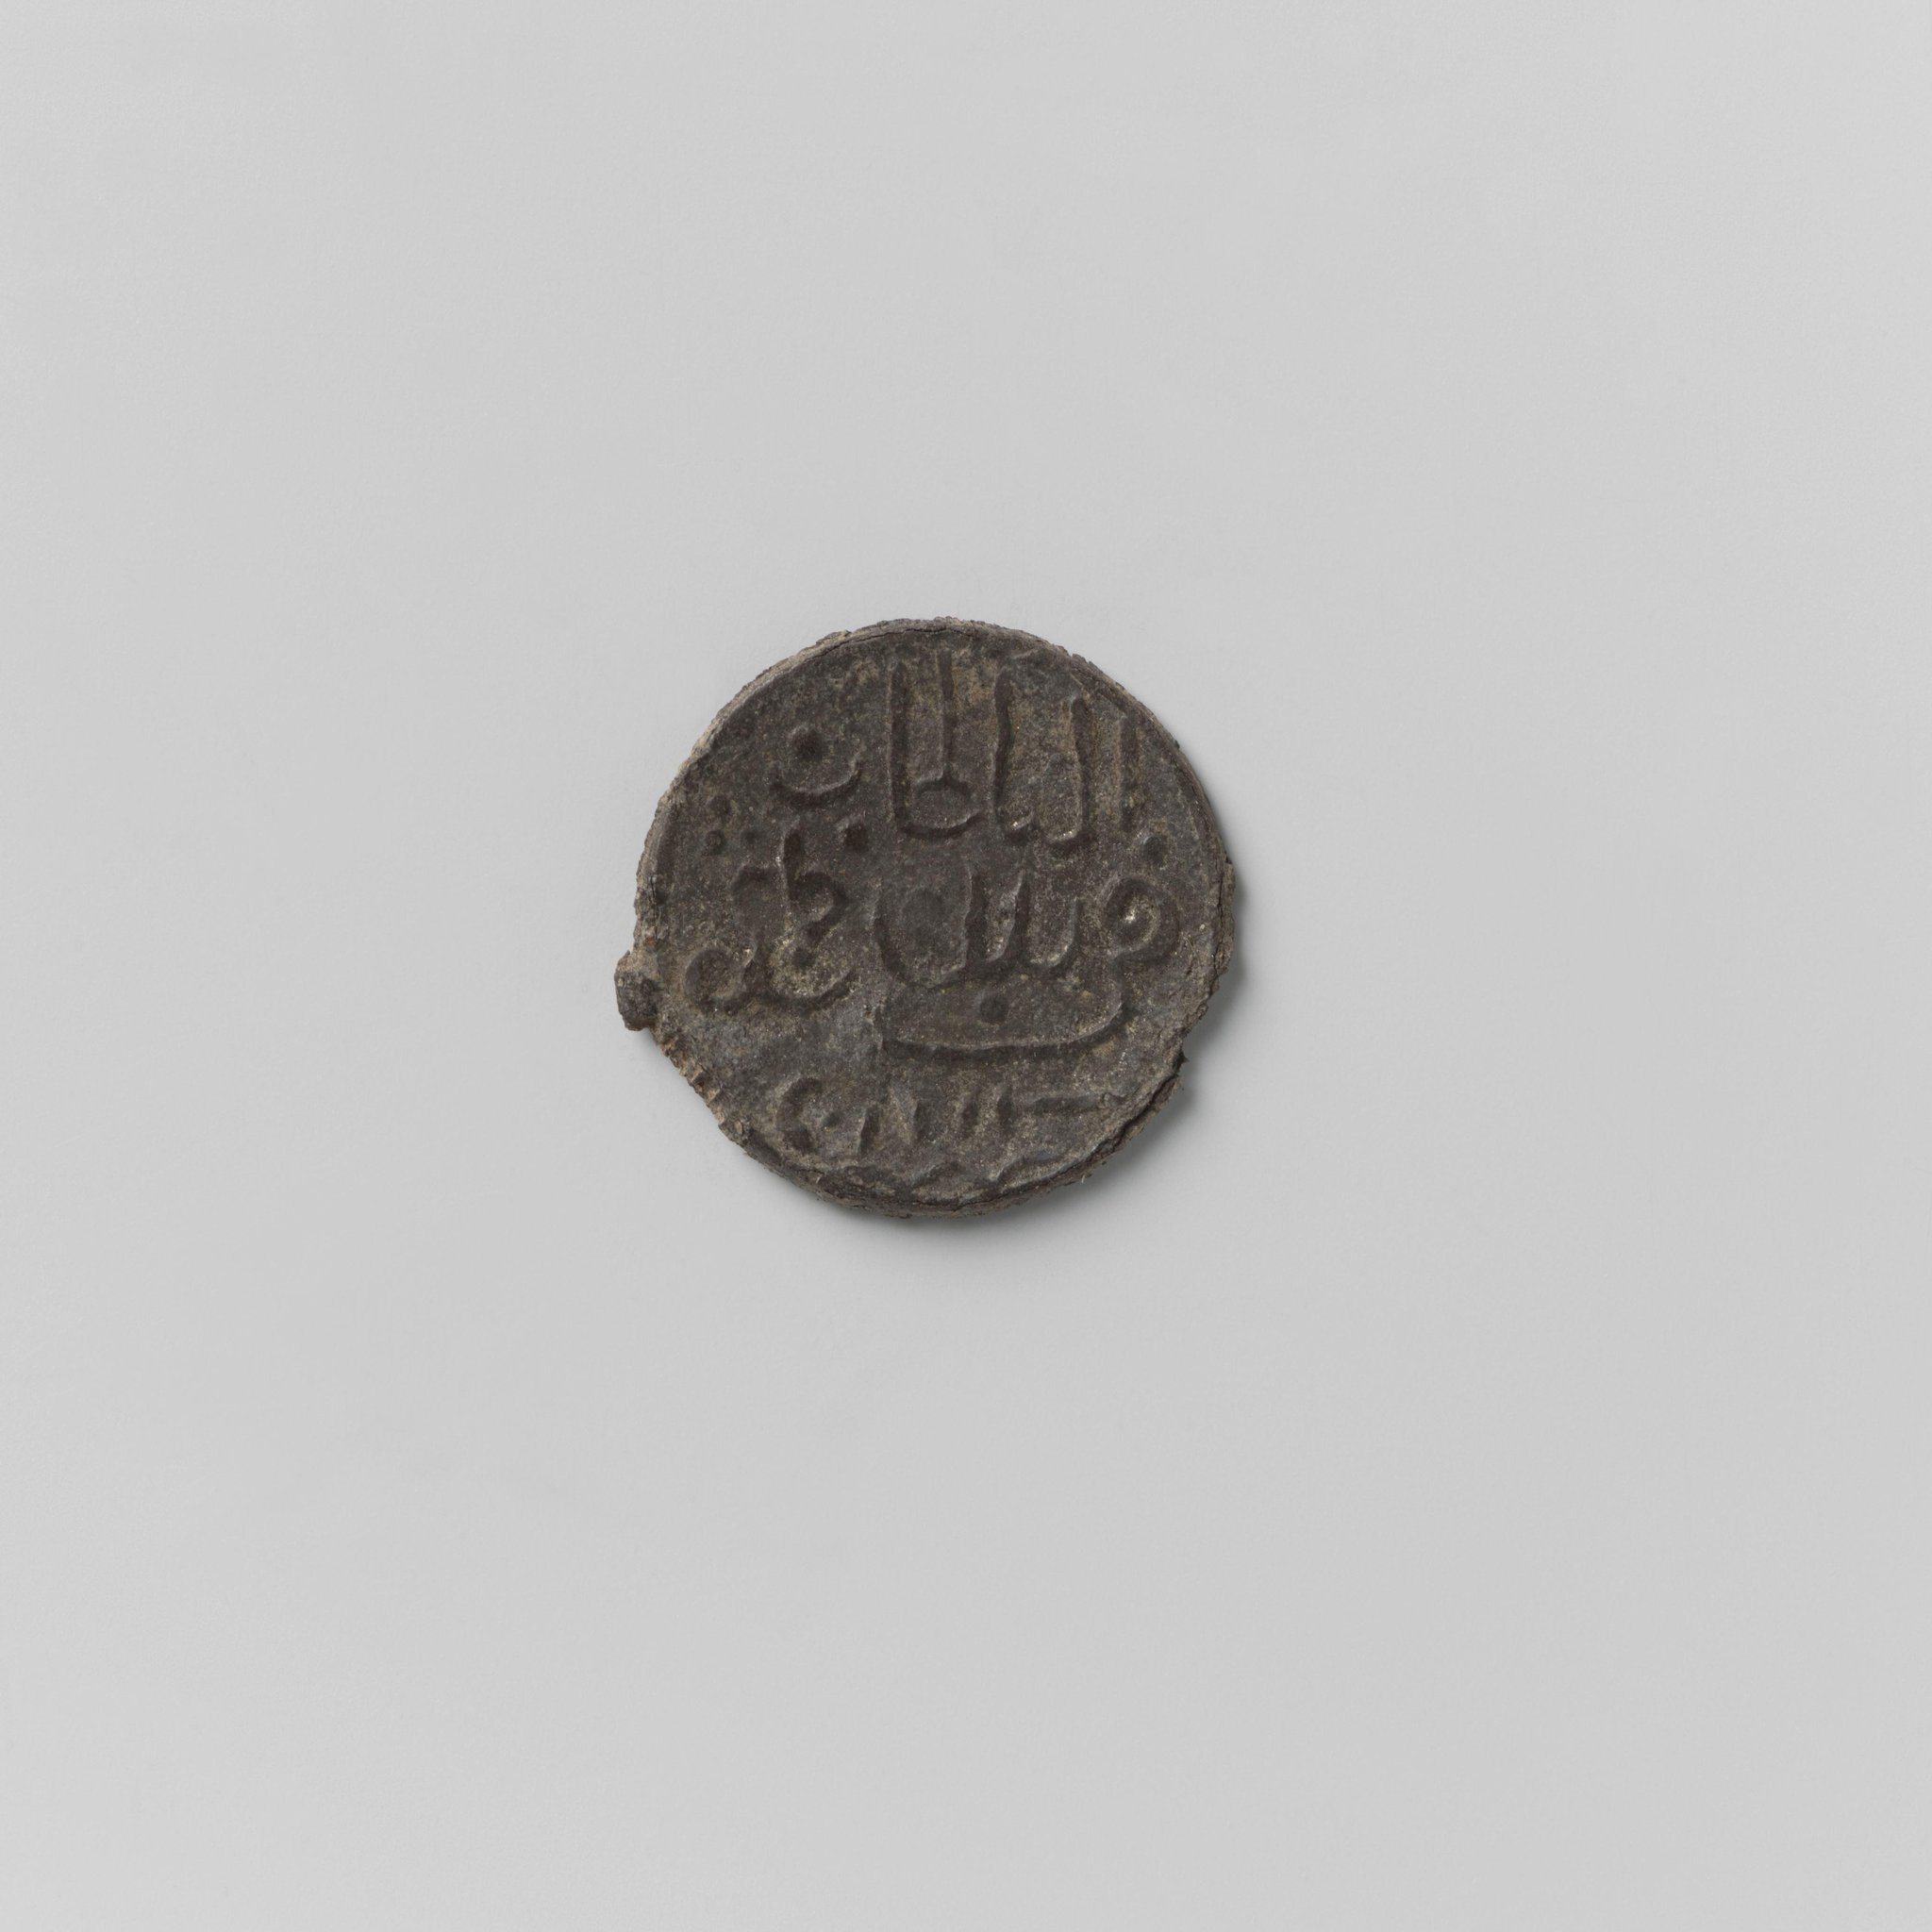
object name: coin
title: Pitji van sultan Mohammed Beha ed-din van Palembang, Sumatra, A.H. 1193 (1779)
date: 1779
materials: tin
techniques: casting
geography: palembang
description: Tinnen munt. Voorzijde: drieregelig opschrift in Arabische lettertekens, waartussen jaartal in Islamitische jaartelling. Keerzijde, glad.